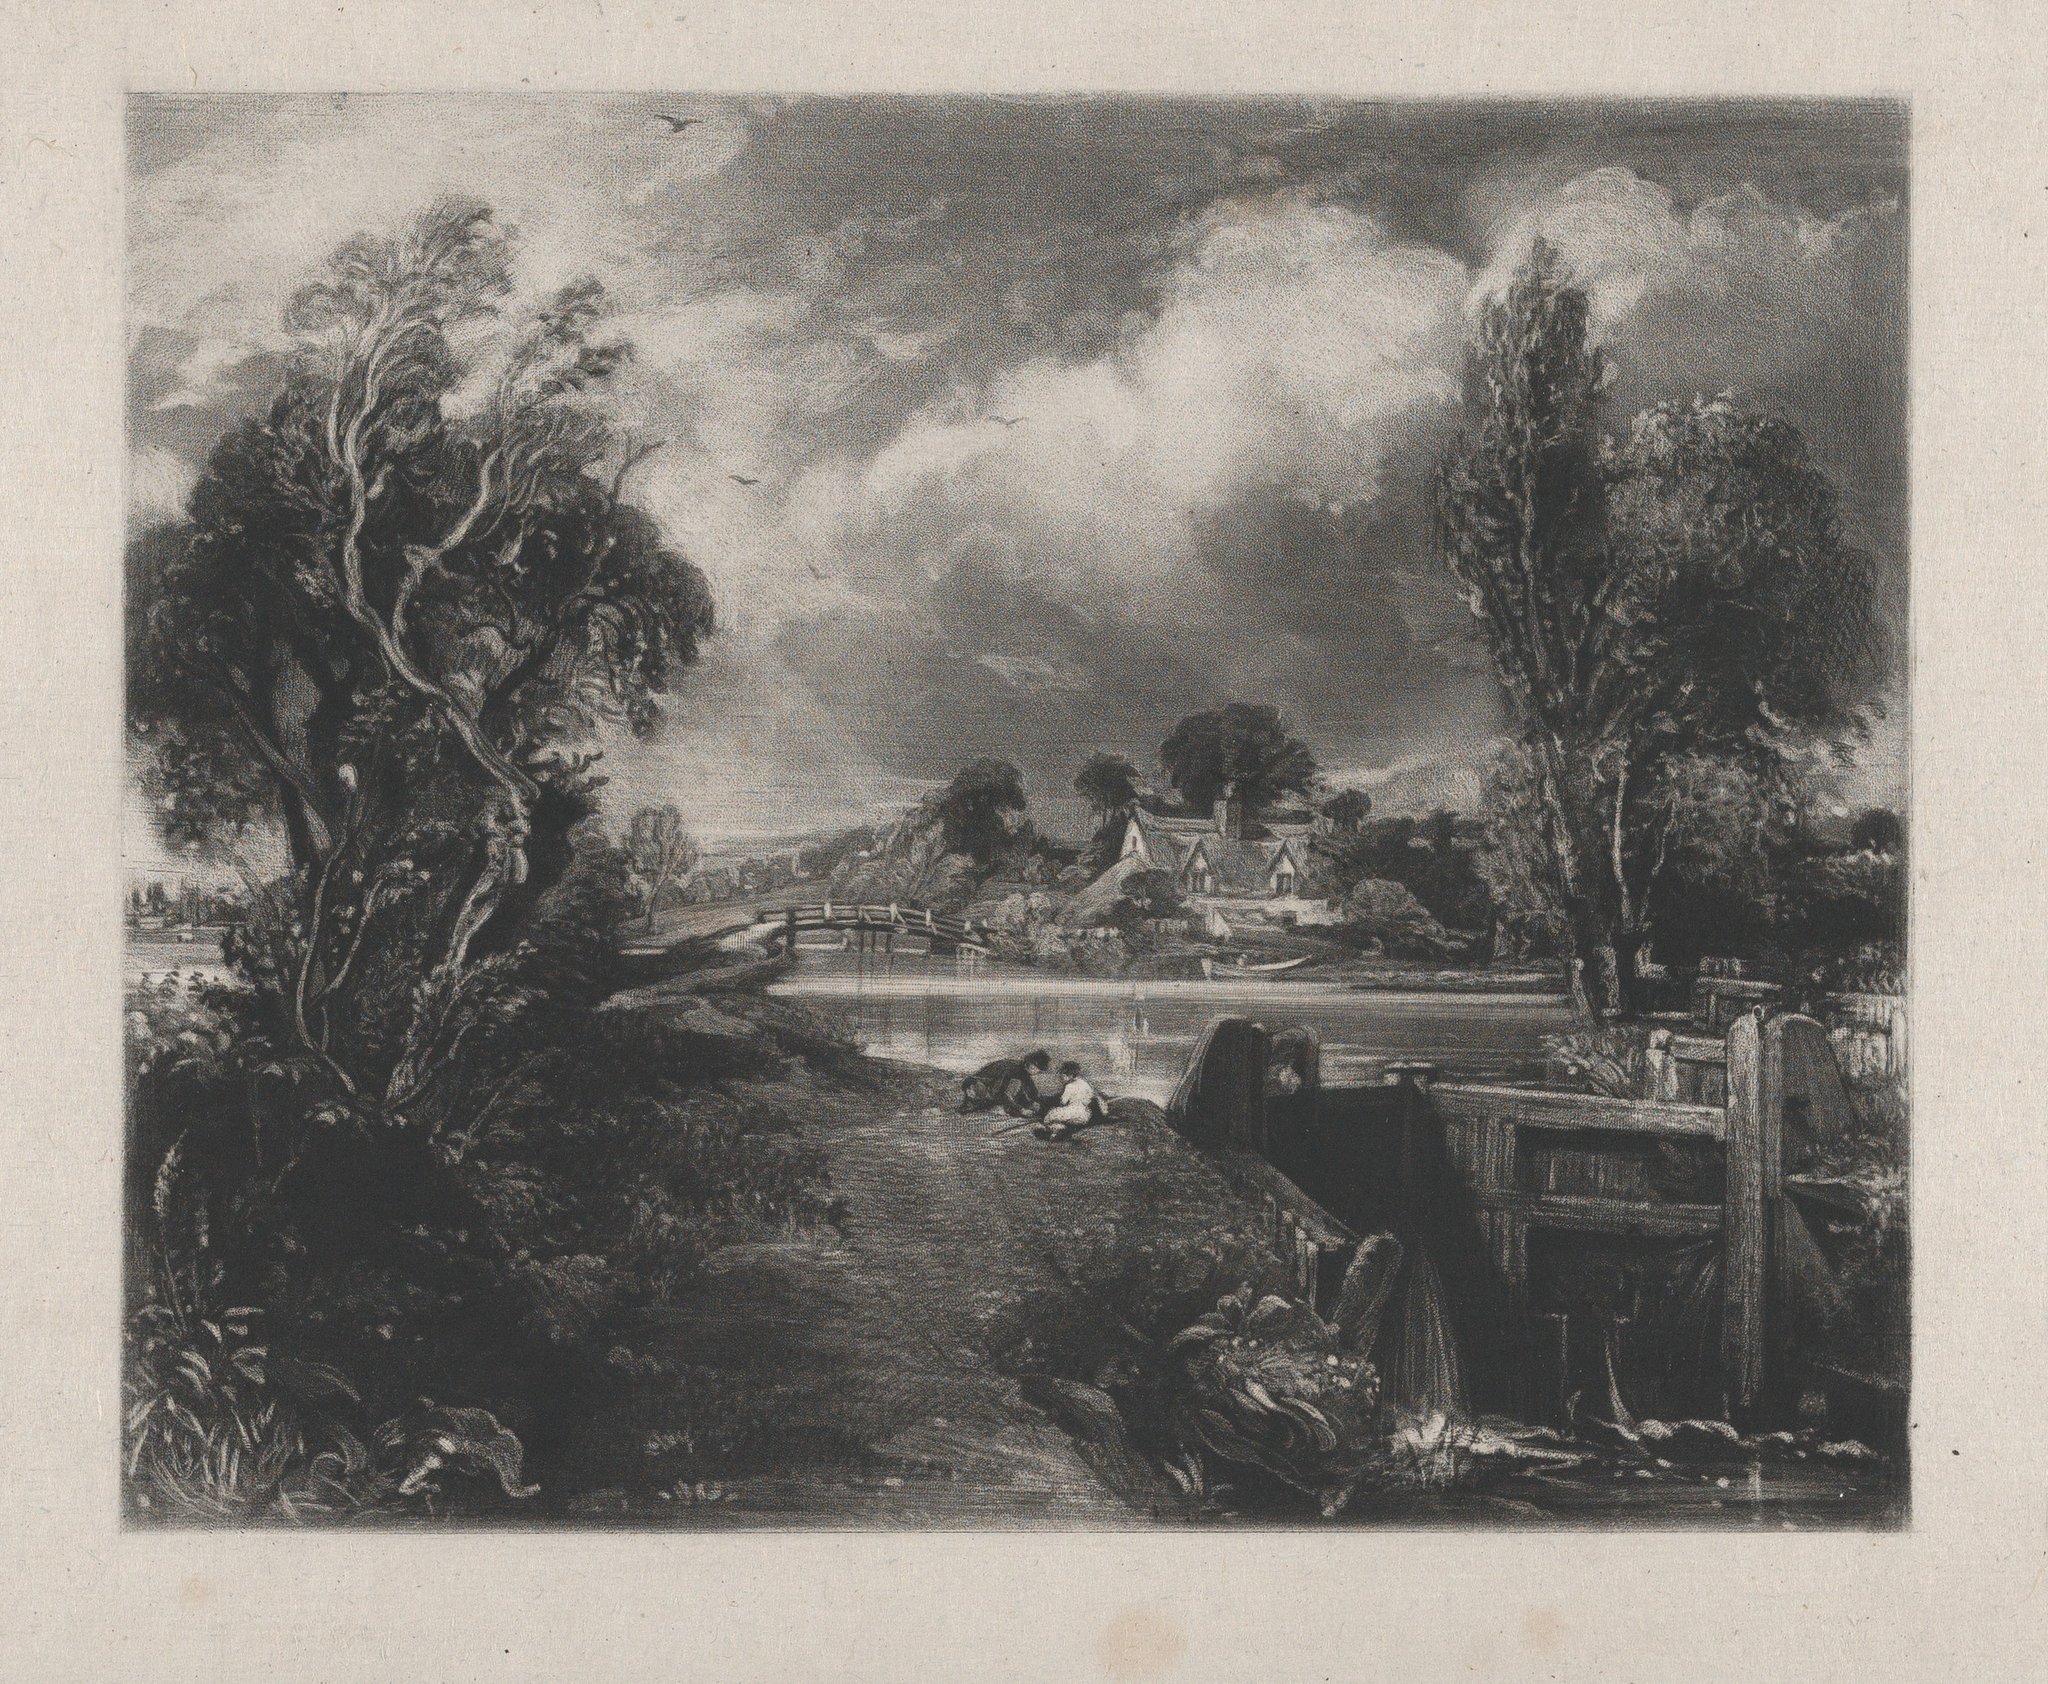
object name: print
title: A Lock on the Stour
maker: david lucas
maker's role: artist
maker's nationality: british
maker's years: 1802-1881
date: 1830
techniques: printmaking, mezzotint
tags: human figures,rivers,landscapes,trees